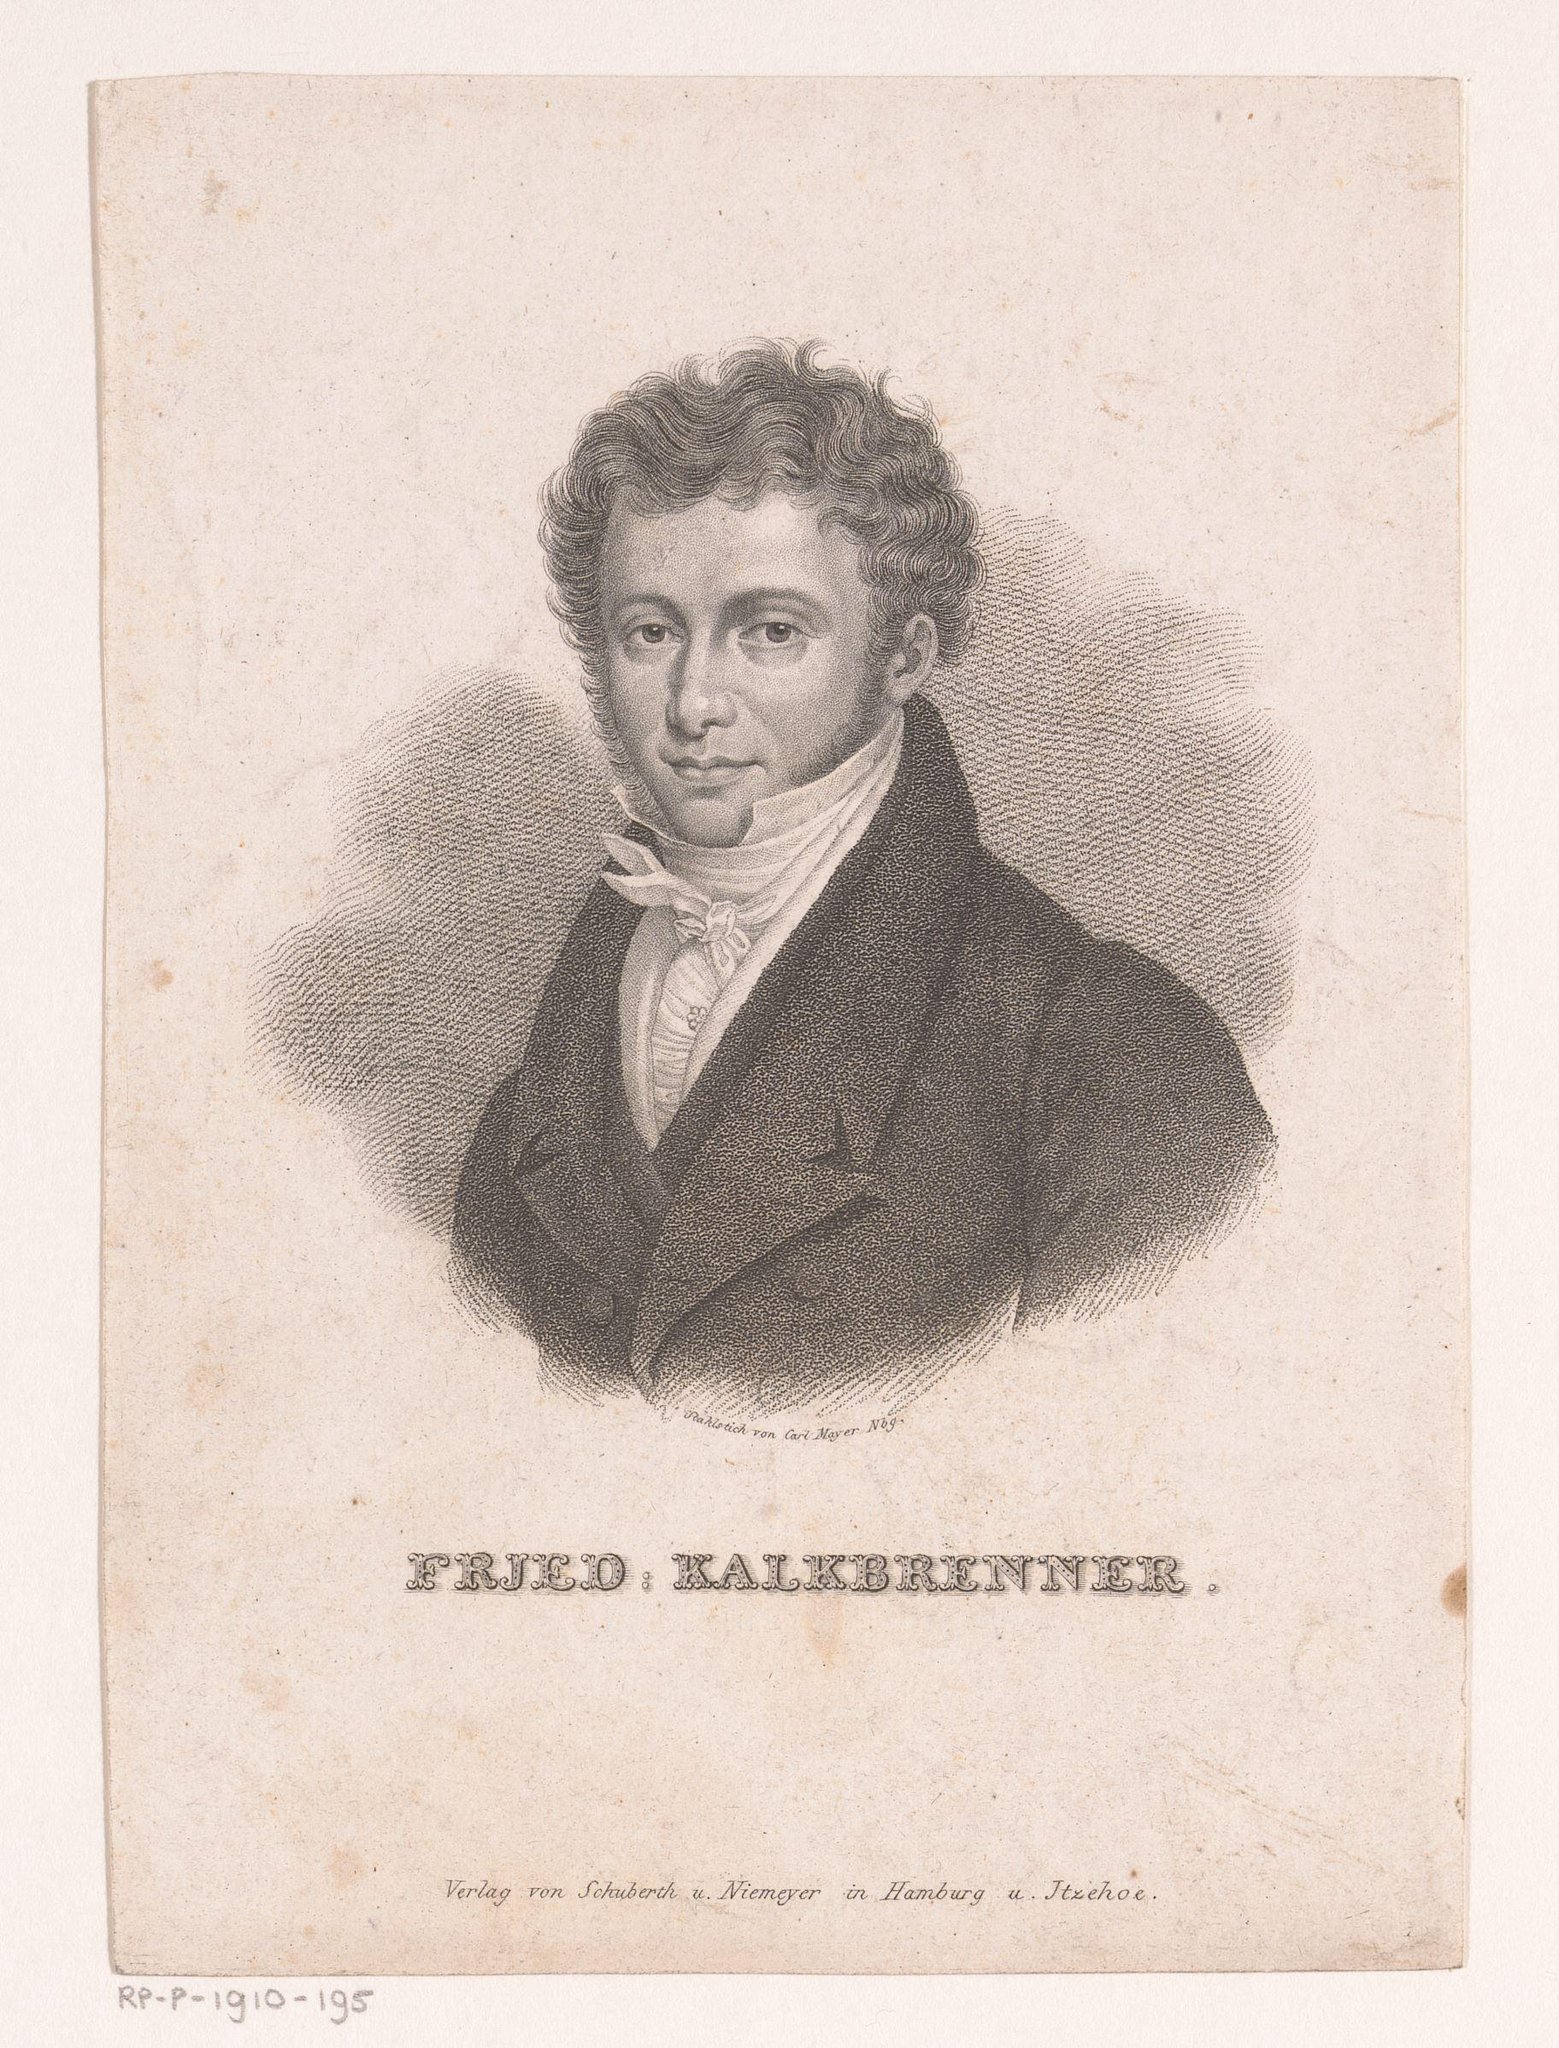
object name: print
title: Portret van Friedrich Kalkbrenner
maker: carl mayer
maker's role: print maker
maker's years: 1798-1868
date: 1808-1868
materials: paper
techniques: engraving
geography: hamburg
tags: historical persons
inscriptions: collector's mark: Lugt 2228